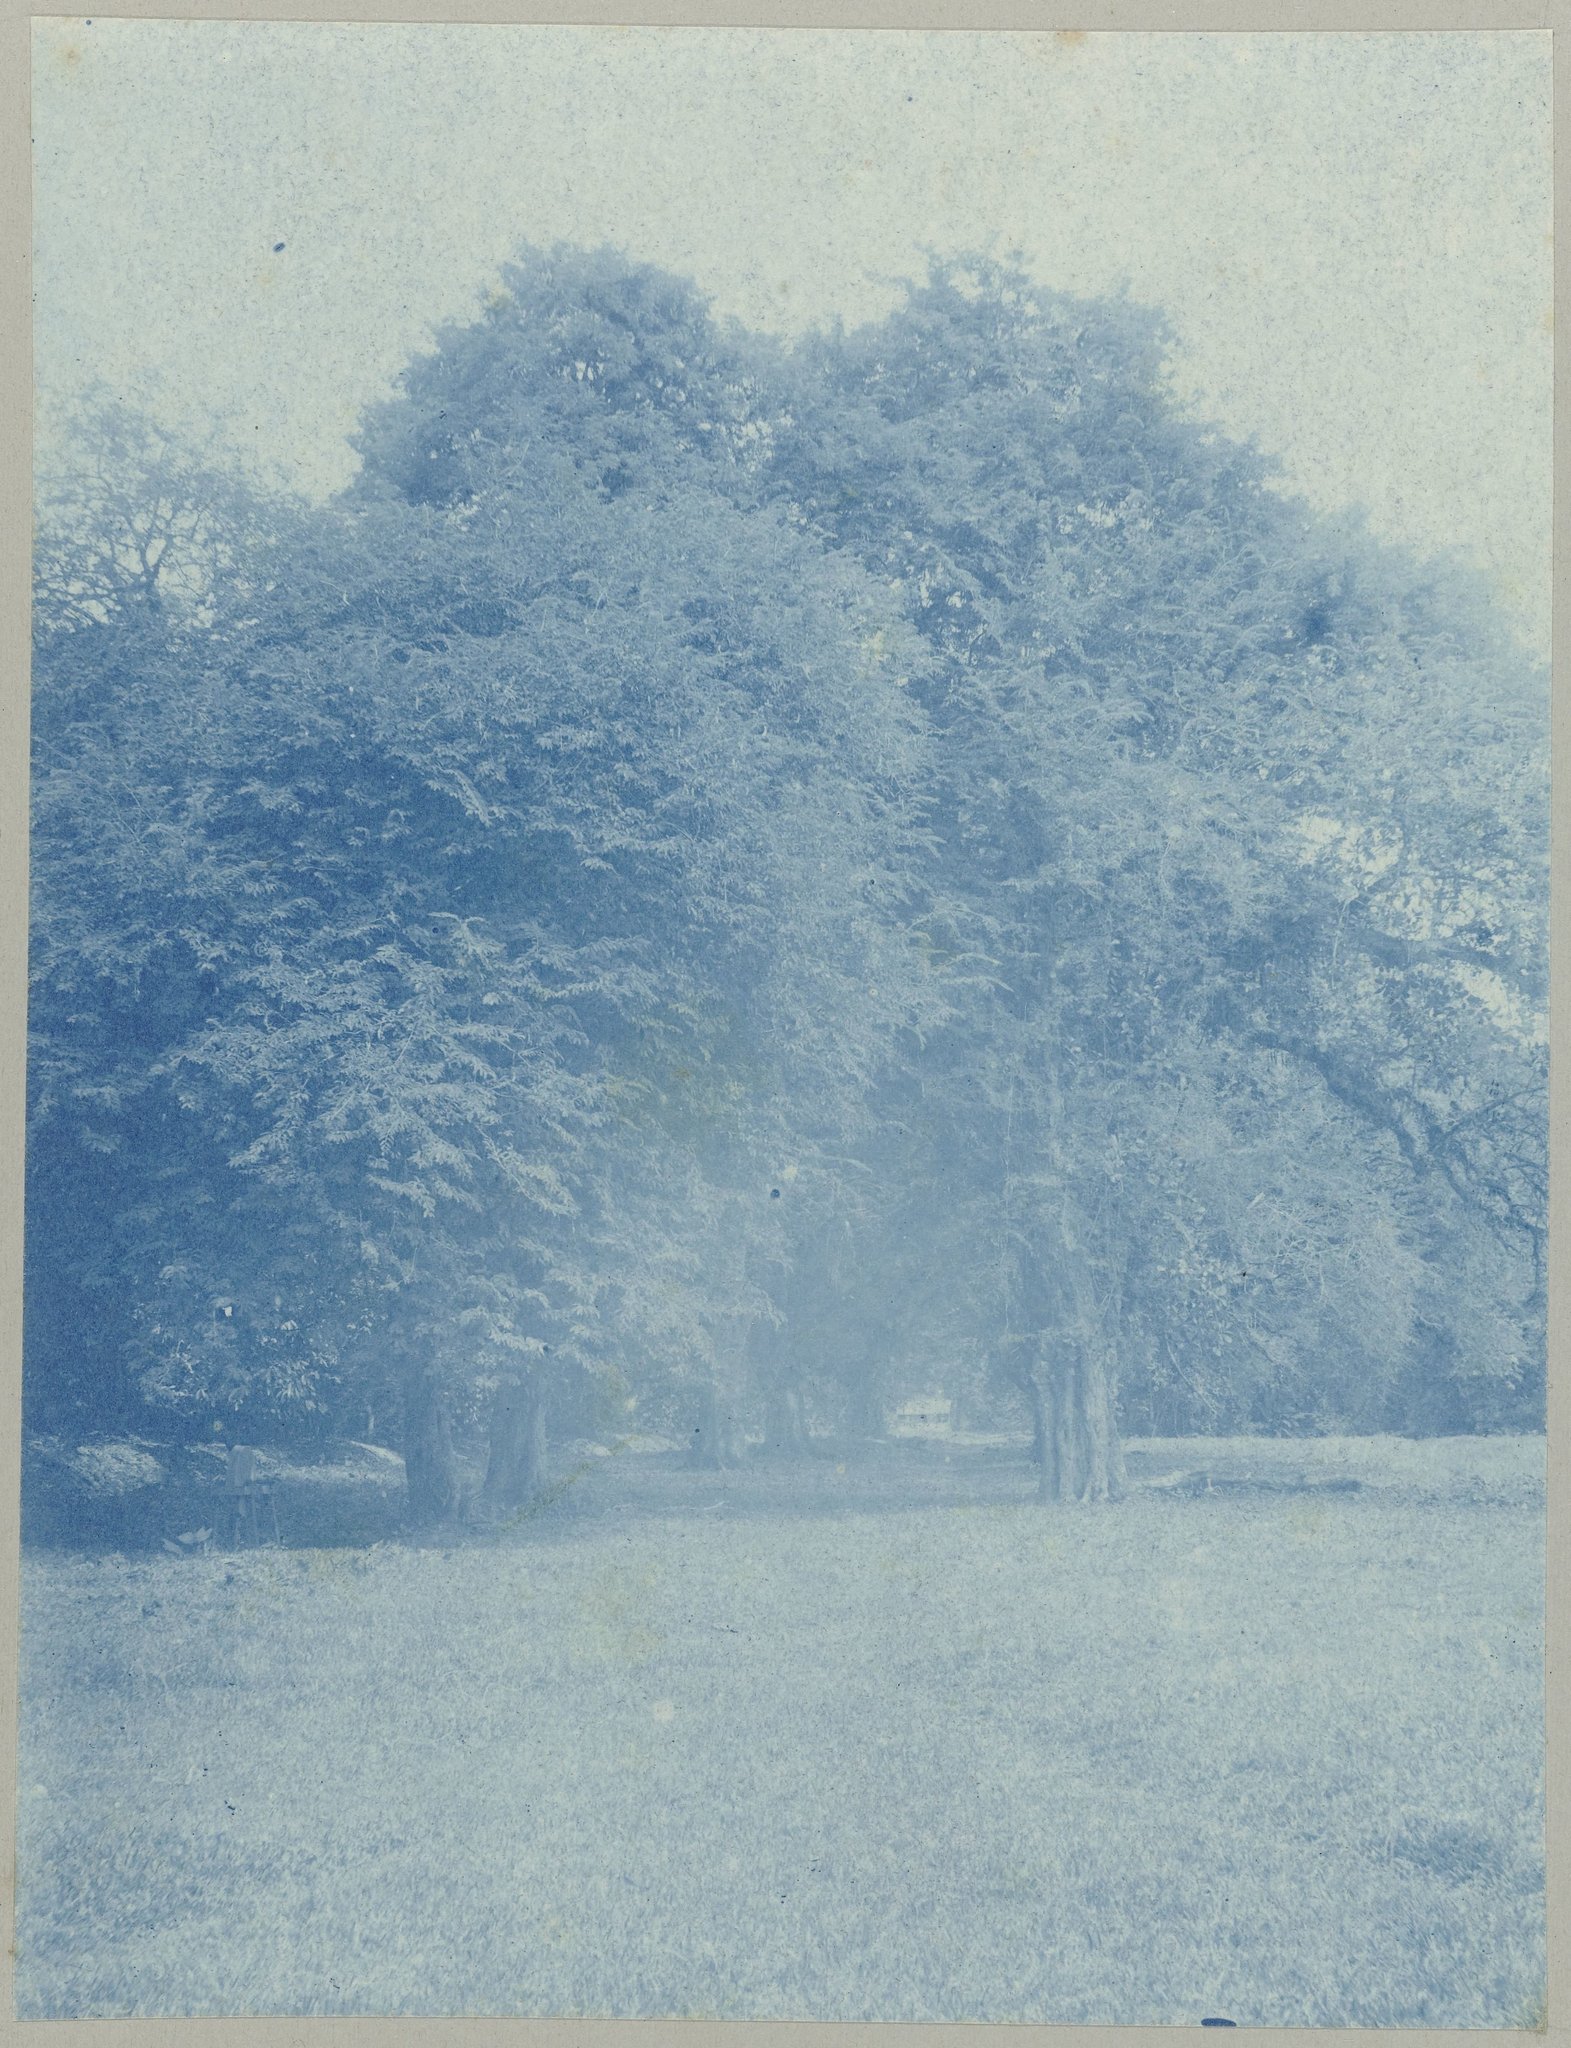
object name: photograph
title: Tamarindegroepen op Tourtonne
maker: hendrik doijer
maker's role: engineer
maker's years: 1863-1925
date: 1903-1910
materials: photographic support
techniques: cyanotype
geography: suriname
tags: suriname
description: Groepen hoge tamarindebomen op de plantage Tourtonne. Onderdeel van het fotoalbum Souvenir de Voyage (deel 2), over het leven van de familie Doijer in en rond de plantage Ma Retraite in Suriname in de jaren 1903-1910.